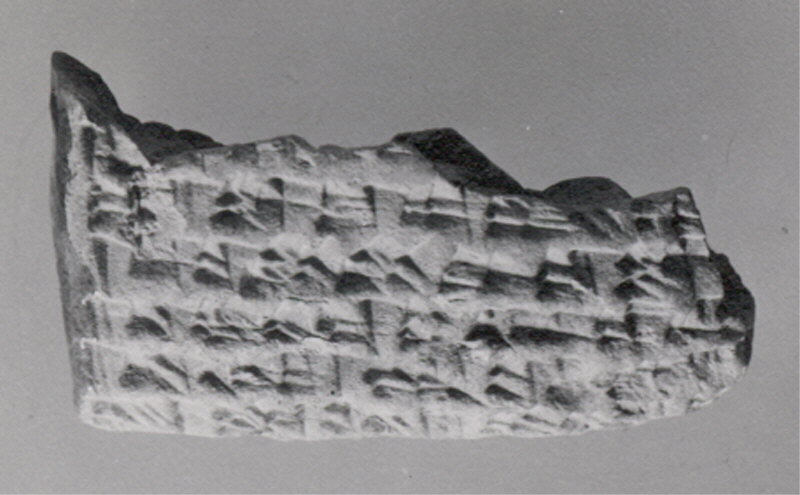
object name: cuneiform tablet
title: Cuneiform tablet: account of commodity issue, Ebabbar archive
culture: babylonian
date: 560-556 BCE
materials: clay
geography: mesopotamia